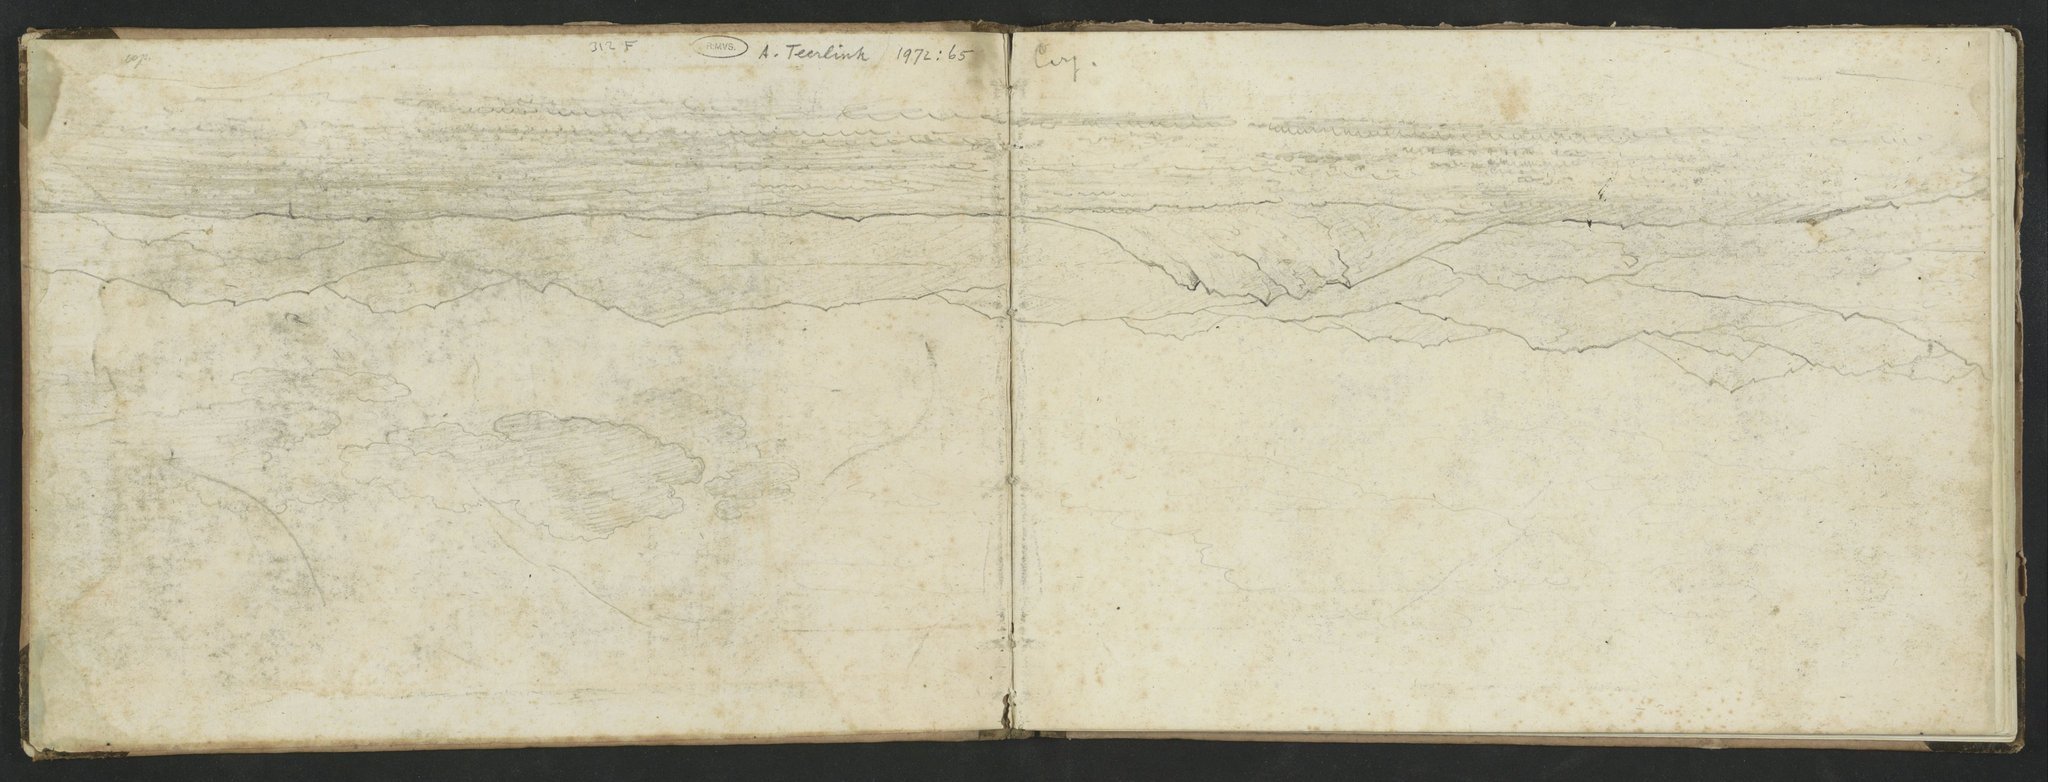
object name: endleaf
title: Berglandschap met meer te Latium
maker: abraham teerlink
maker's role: draughtsman, painter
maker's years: 1776-1857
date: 1808-1857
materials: paper, pencil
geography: latium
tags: lake, mountain-range, snow peaks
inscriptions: annotation: ‘Cer[...]/ dos’, collector's mark: Lugt 2228a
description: Voorste schutblad en blad 1 recto uit een schetsboek met 28 bladen.